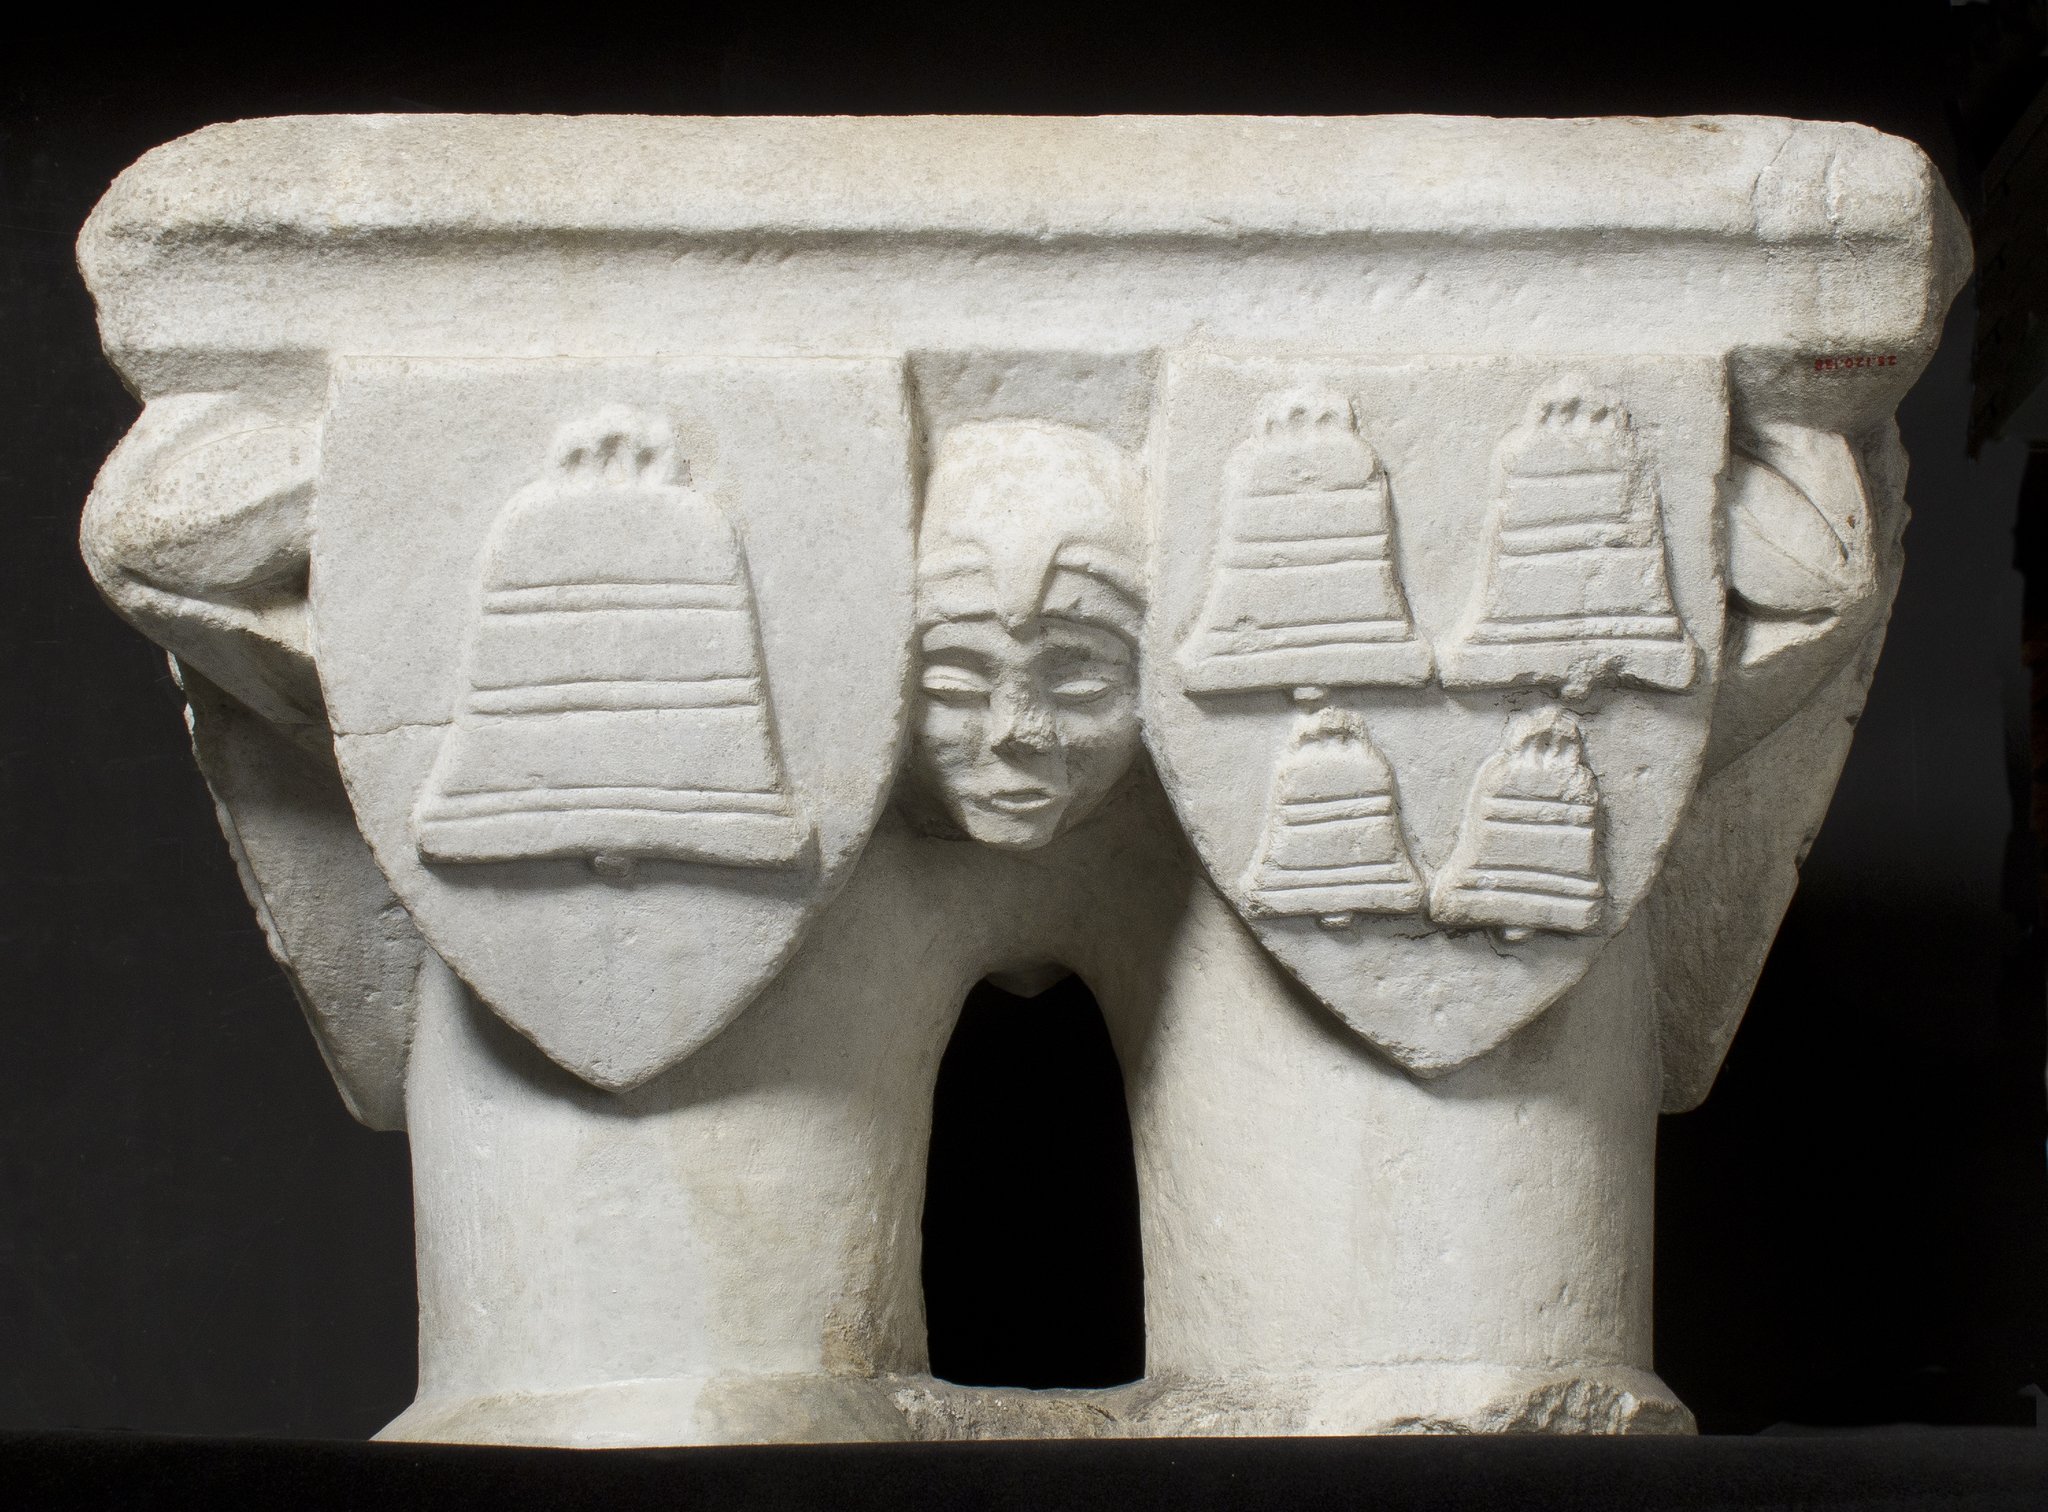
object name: capital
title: Double Capital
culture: french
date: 1450-1500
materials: marble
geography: trie or st. sever de rustan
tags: faces,bells